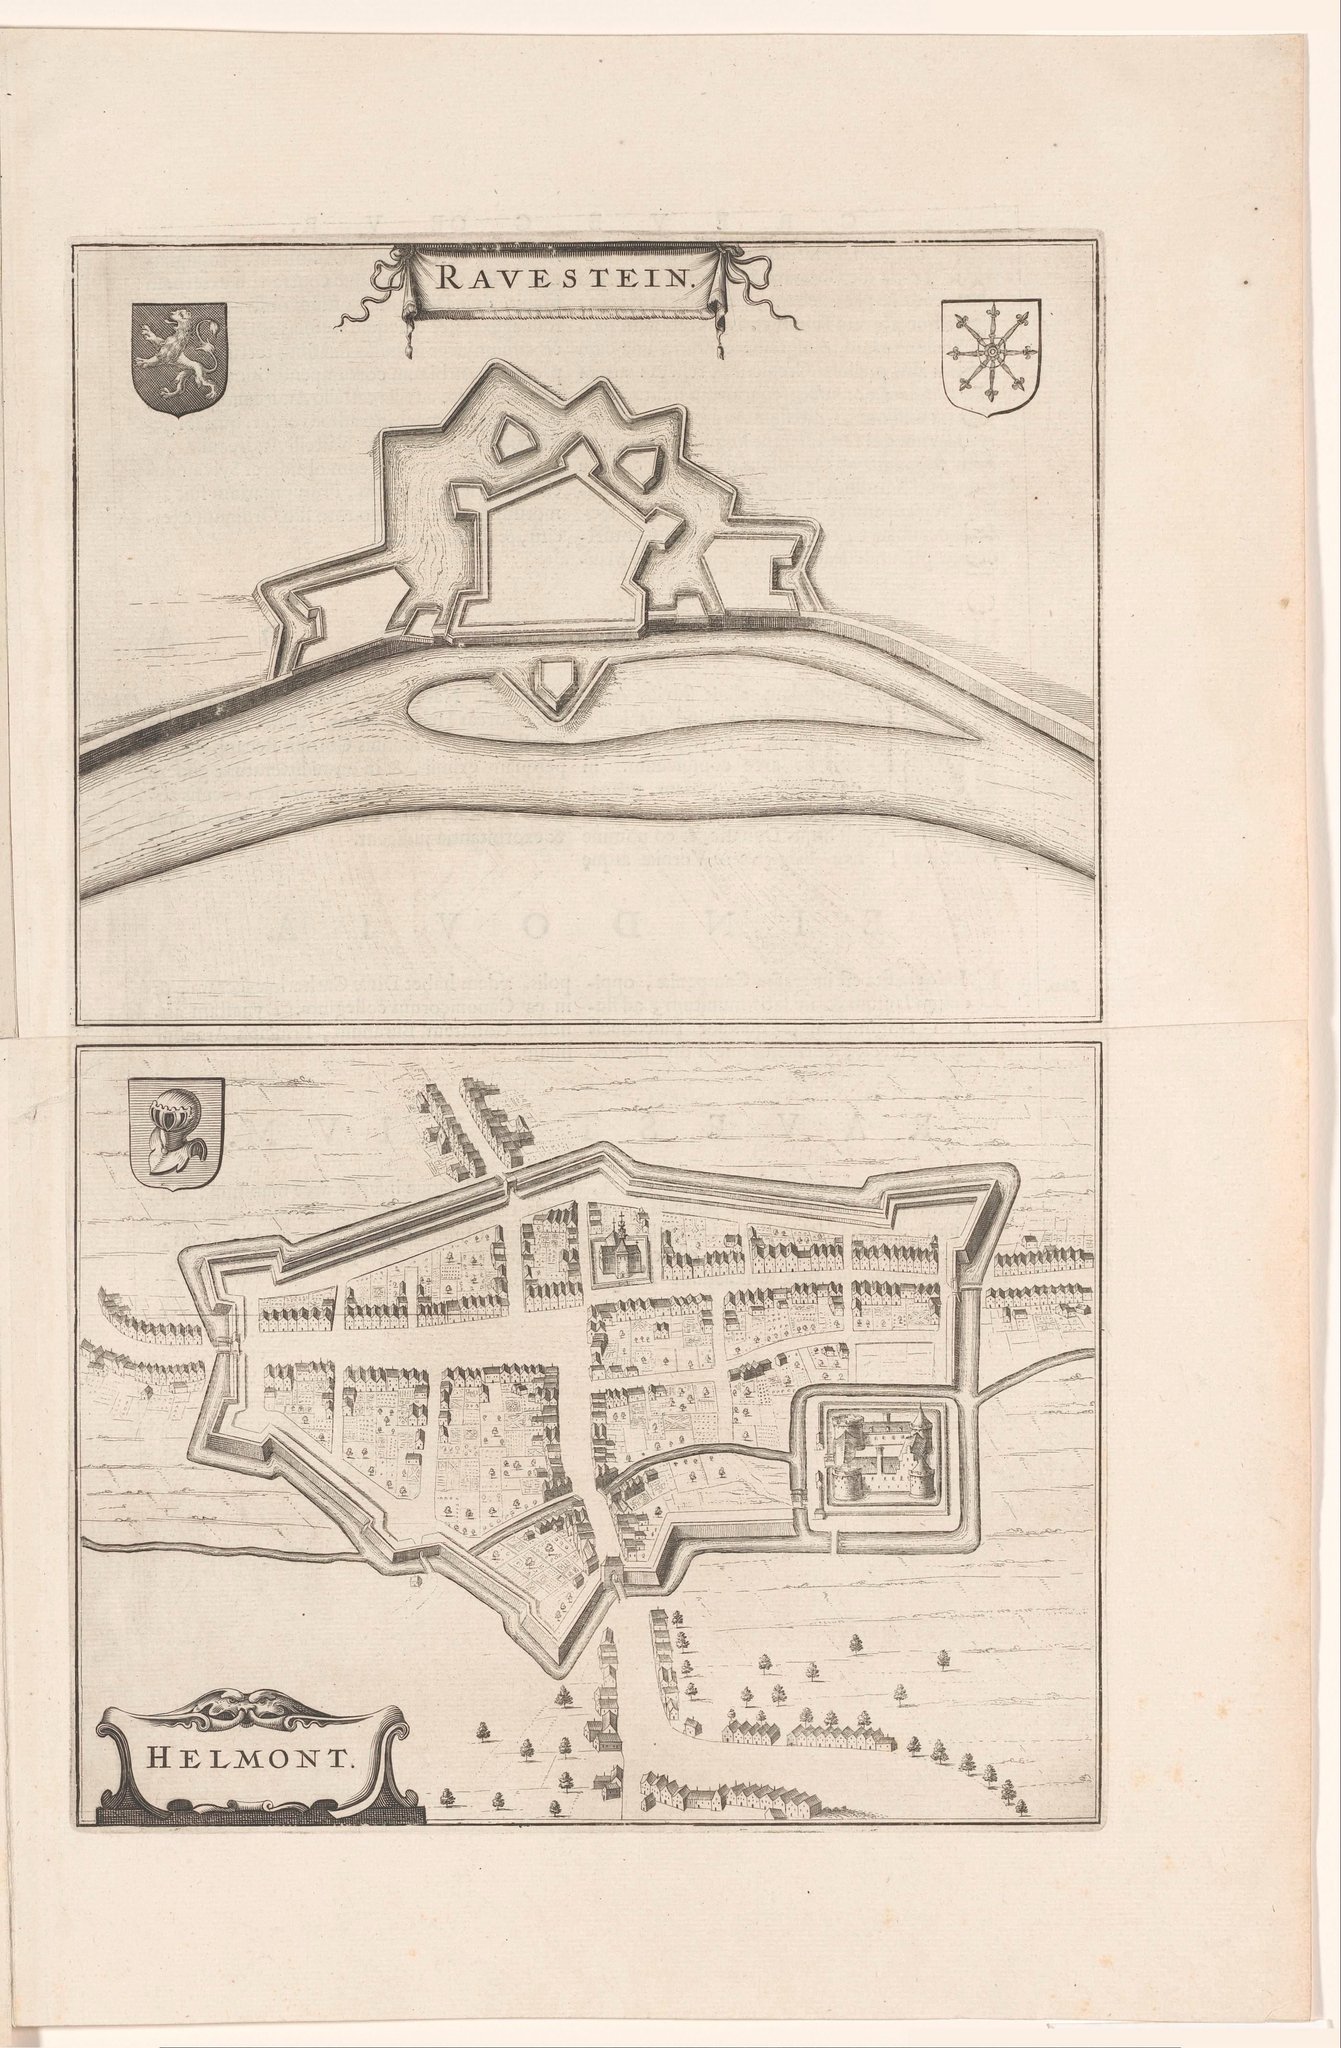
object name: print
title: Vestingplattegronden van Fort Crèvecoeur, Ravenstein en Helmond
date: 1652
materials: paper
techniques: engraving, etching, letterpress printing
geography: amsterdam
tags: coat of arms (as symbol of the state, etc.) (+ city; municipal), fortified city, maps of cities, coat of arms (as symbol of the state, etc.) (+ province; provincial)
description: Op het linkerblad een vestingplattegrond van Fort Crèvecoeur. Linksonder een schaalstok: 30 Virgae Roeden. Boven op het rechterblad een vestingplattegrond van Ravenstein. Linksboven het wapen van Brabant en rechtsboven het wapen van Kleef. Boven in het midden een banderol met de titel. Onder op het rechterblad een plattegrond van Helmond in vogelvluchtperspectief. Linksonder de titelcartouche en linksboven het wapen van Helmond. Met Latijnse tekst op verso.